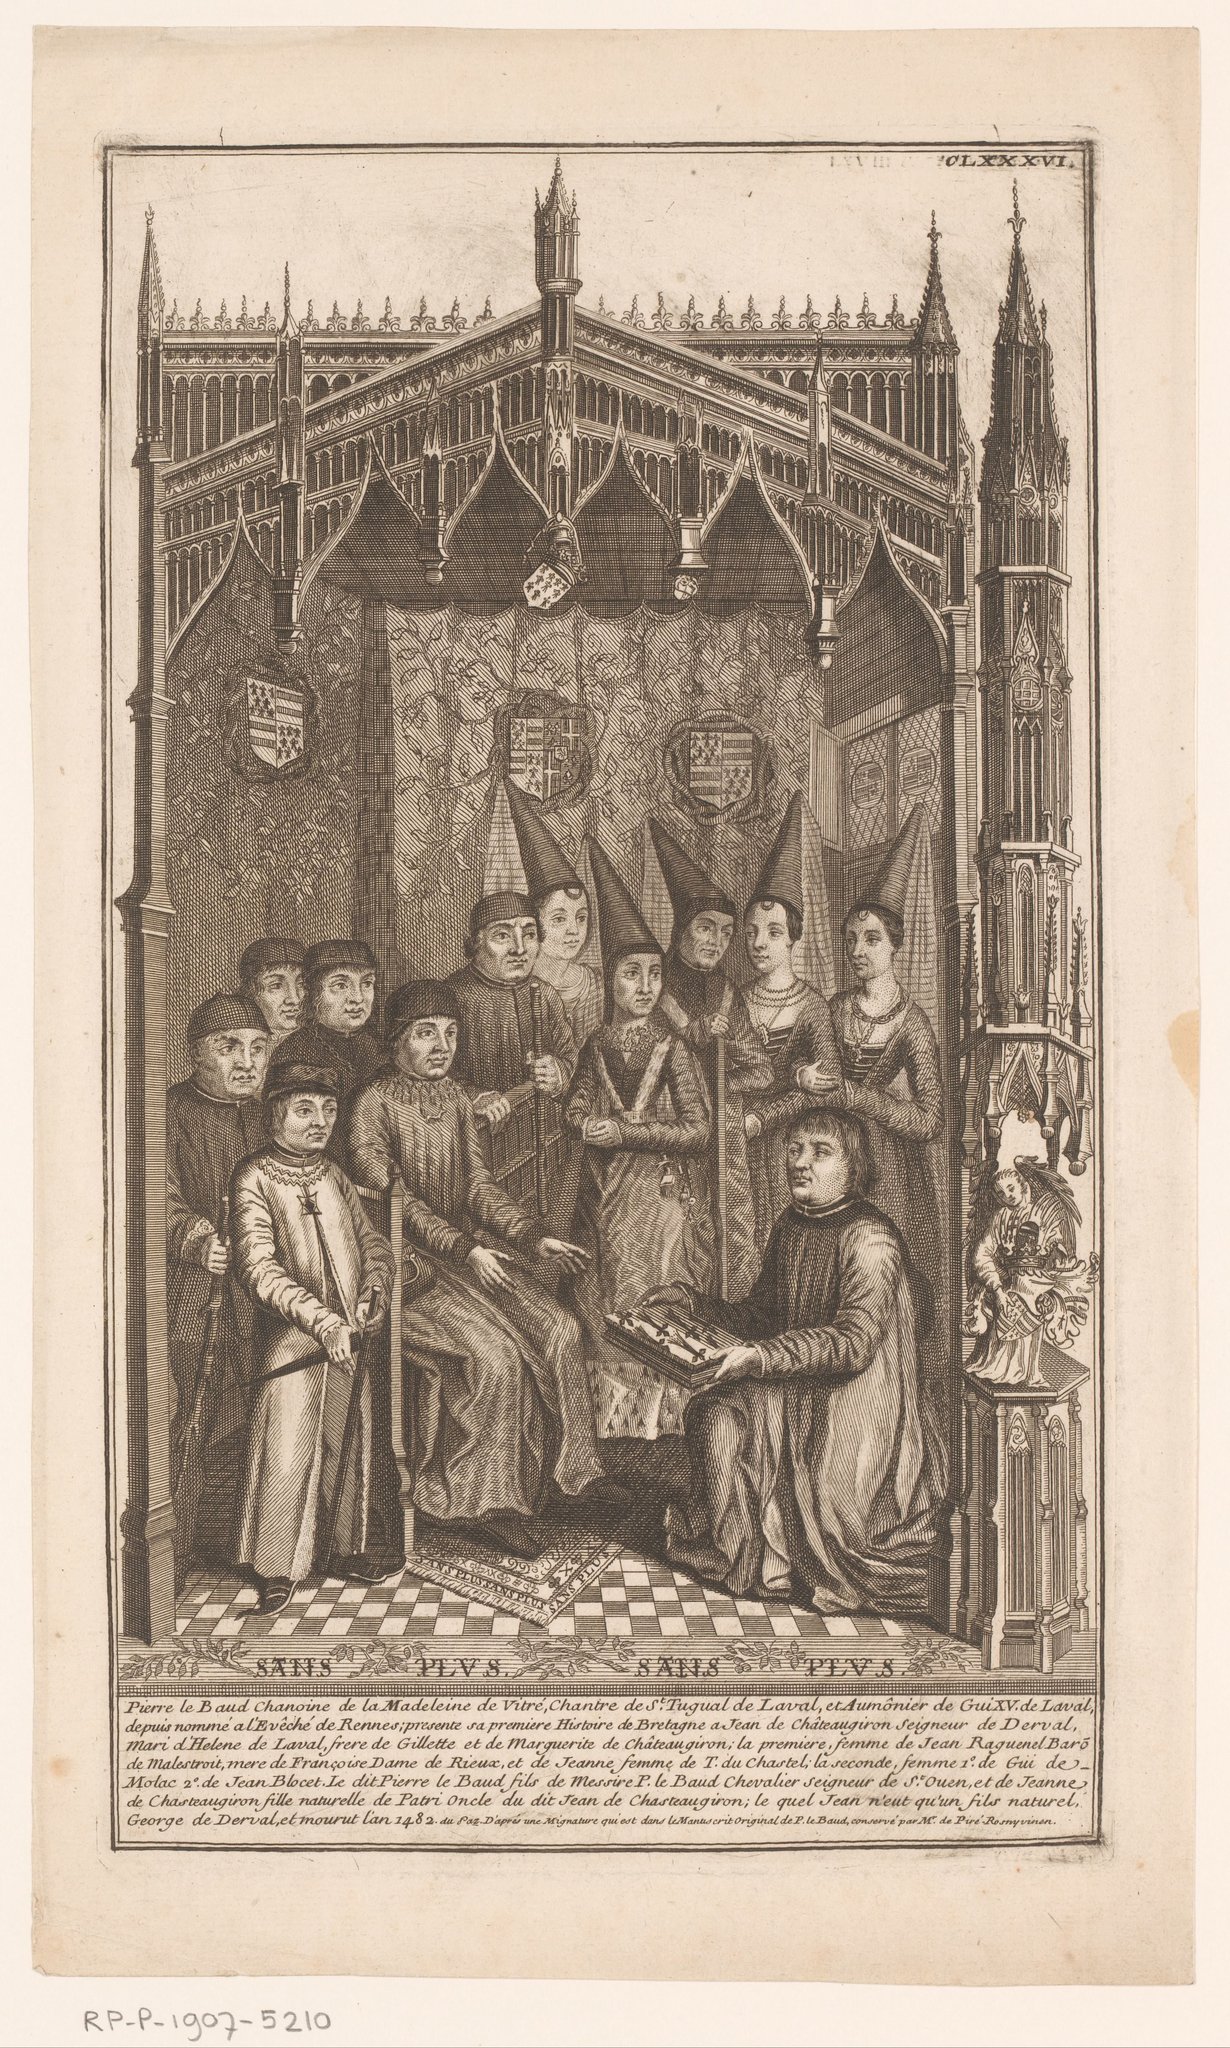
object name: book illustration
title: Portret van adellijk gezelschap waaronder Pierre Le Baud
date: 1729-1733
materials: paper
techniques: engraving, etching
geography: paris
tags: historical persons, nobility and patriciate; chivalry, knighthood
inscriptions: collector's mark: Lugt 2228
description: Prent uit: Montfaucon, Bernard de. Les monumens de la monarchie françoise, qui comprennent l'histoire de France avec les figures de chaque règne que l'injure des tems a épargnées (...). Parijs: Julien-Michel Gandouin en Pierre-François Giffart, 1729-1733, dl. 3, afb. voor p. 355.